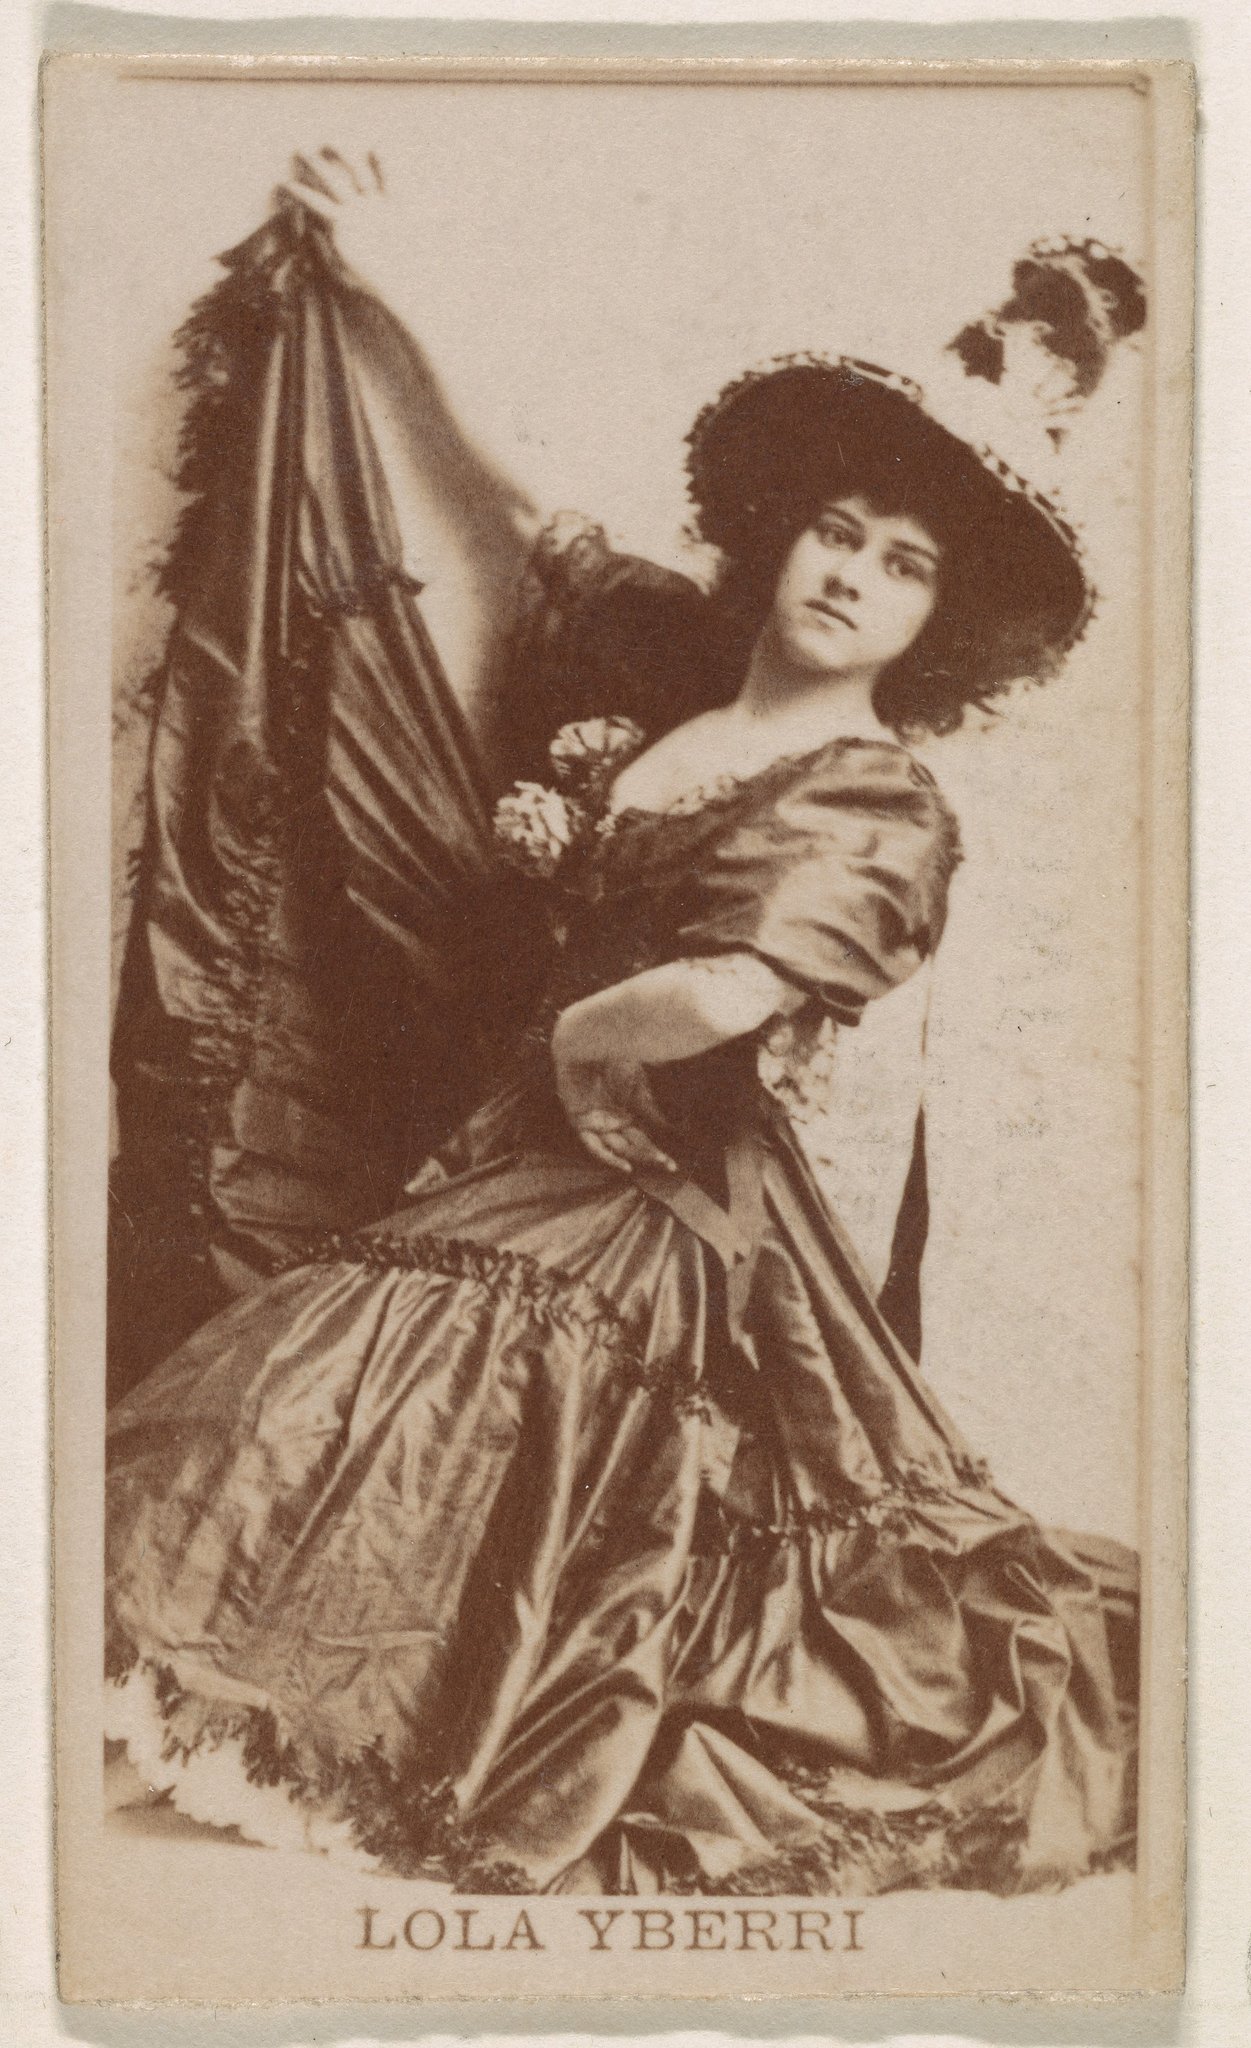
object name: photograph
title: Lola Yberri, from the Actresses series (N245) issued by Kinney Brothers to promote Sweet Caporal Cigarettes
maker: kinney brothers tobacco company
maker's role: publisher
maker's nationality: american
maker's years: 1869-2011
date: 1890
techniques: albumen silver print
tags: portraits,women,actresses